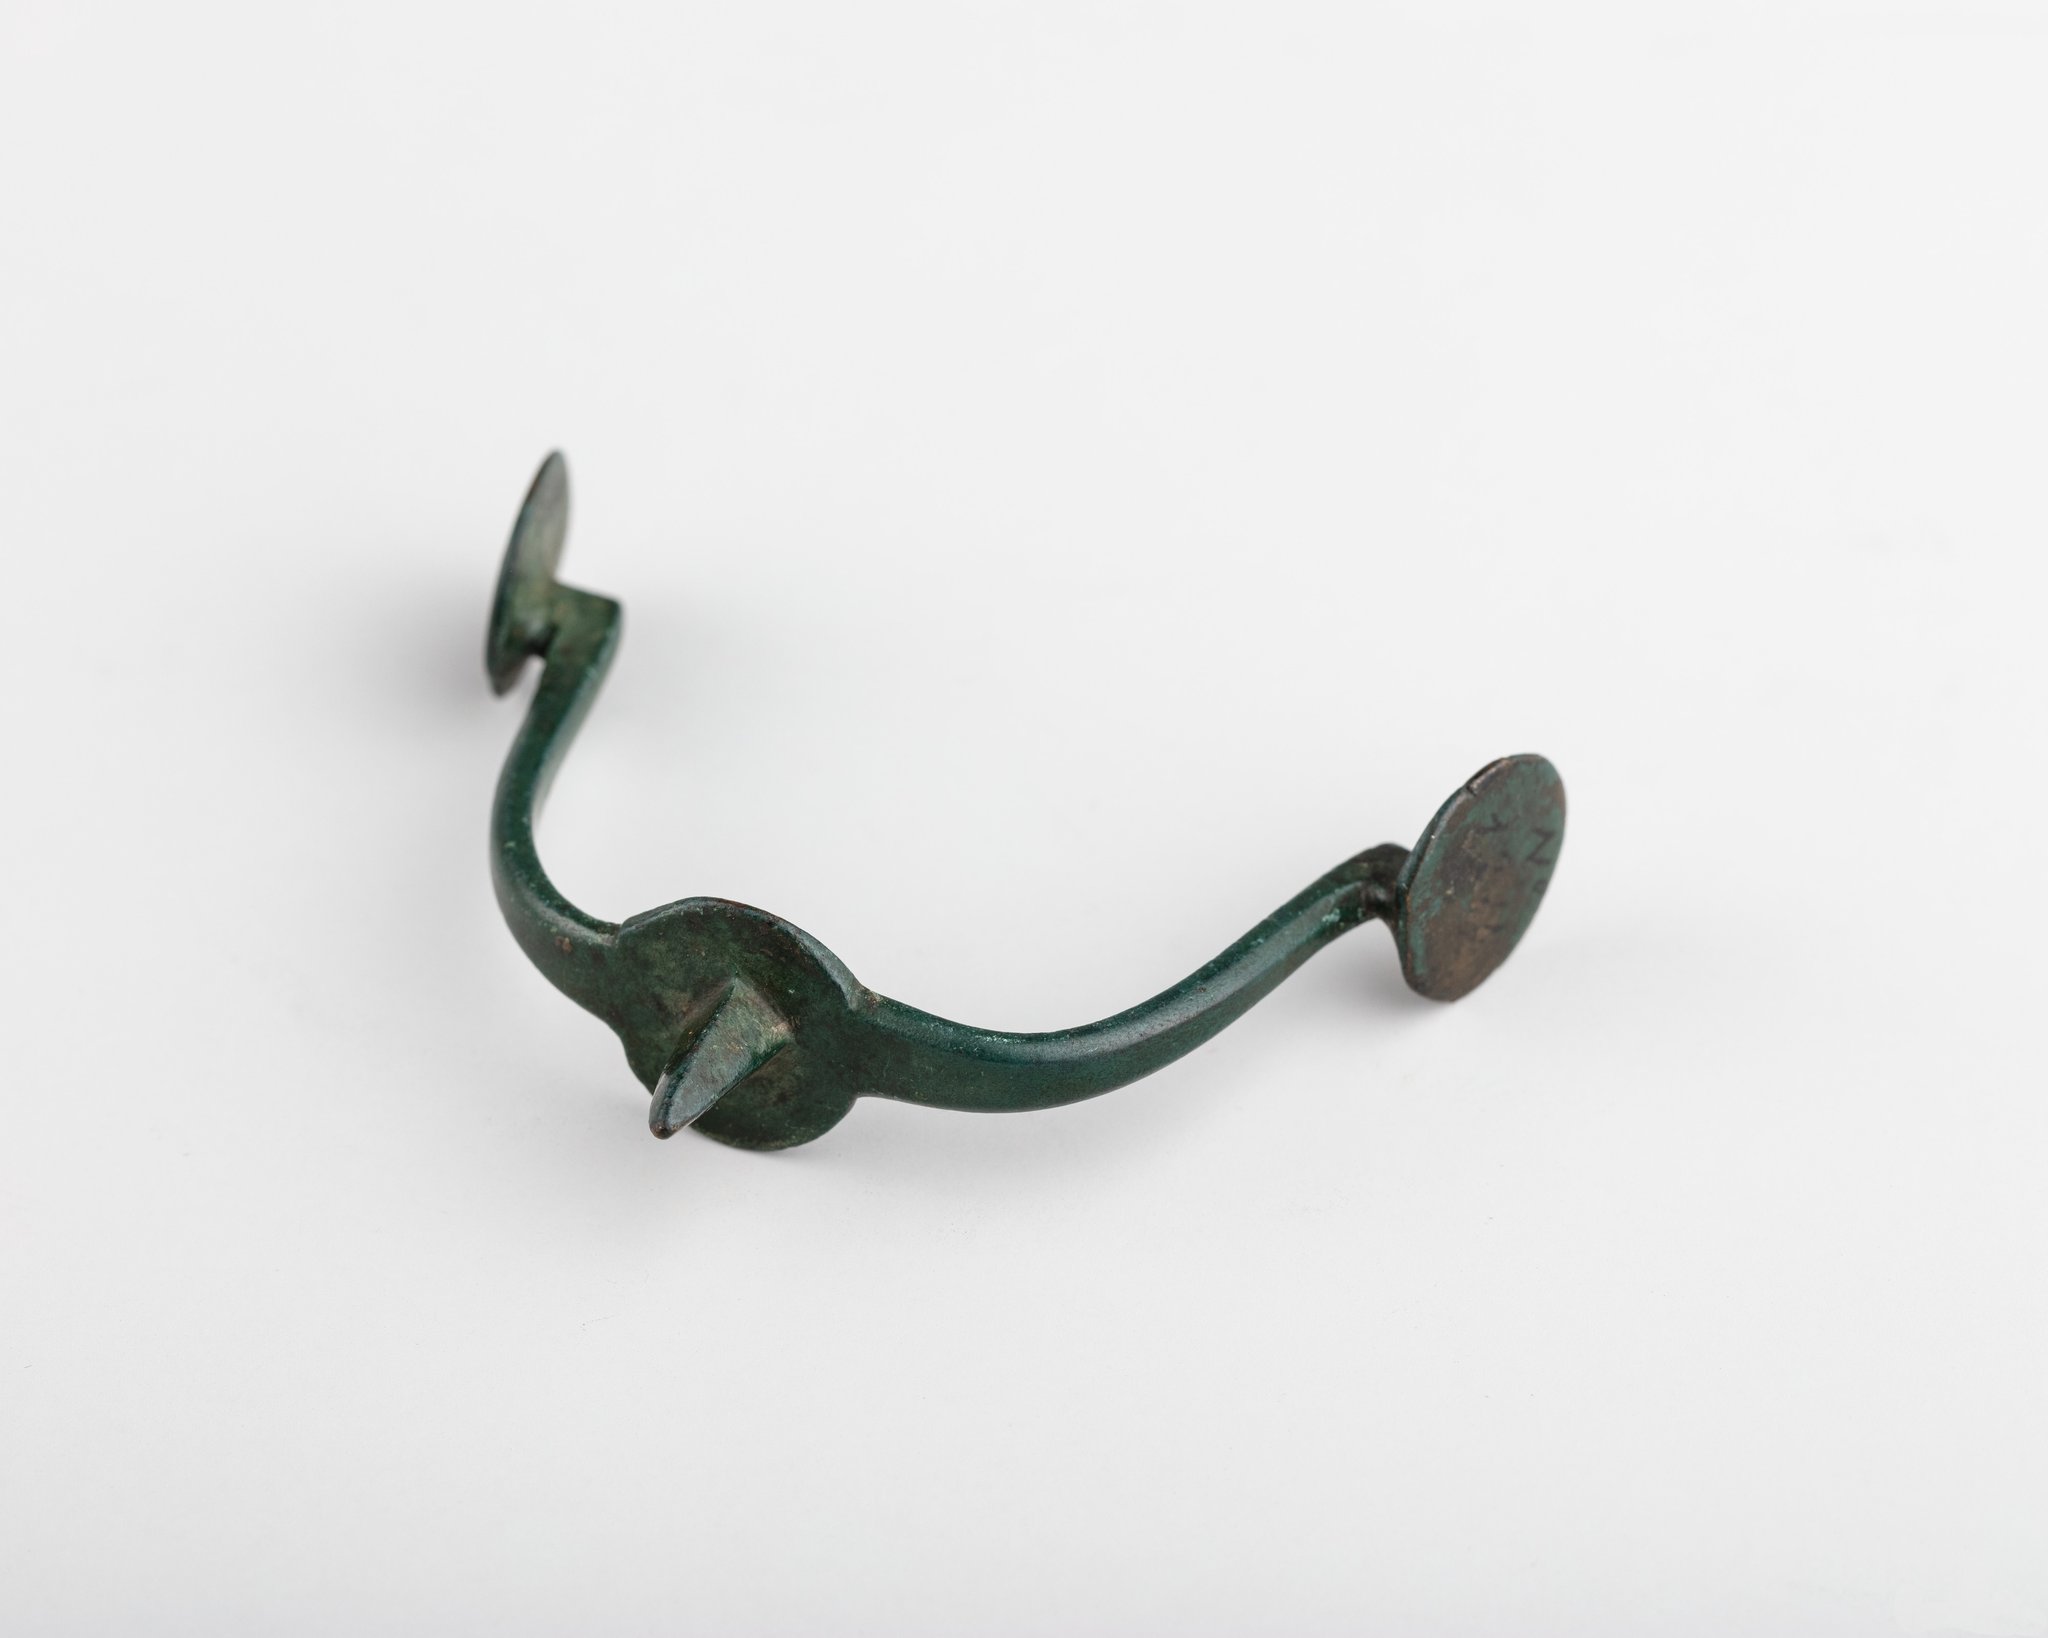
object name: spur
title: Prick Spur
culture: celtic or roman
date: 200-1 BCE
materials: copper alloy